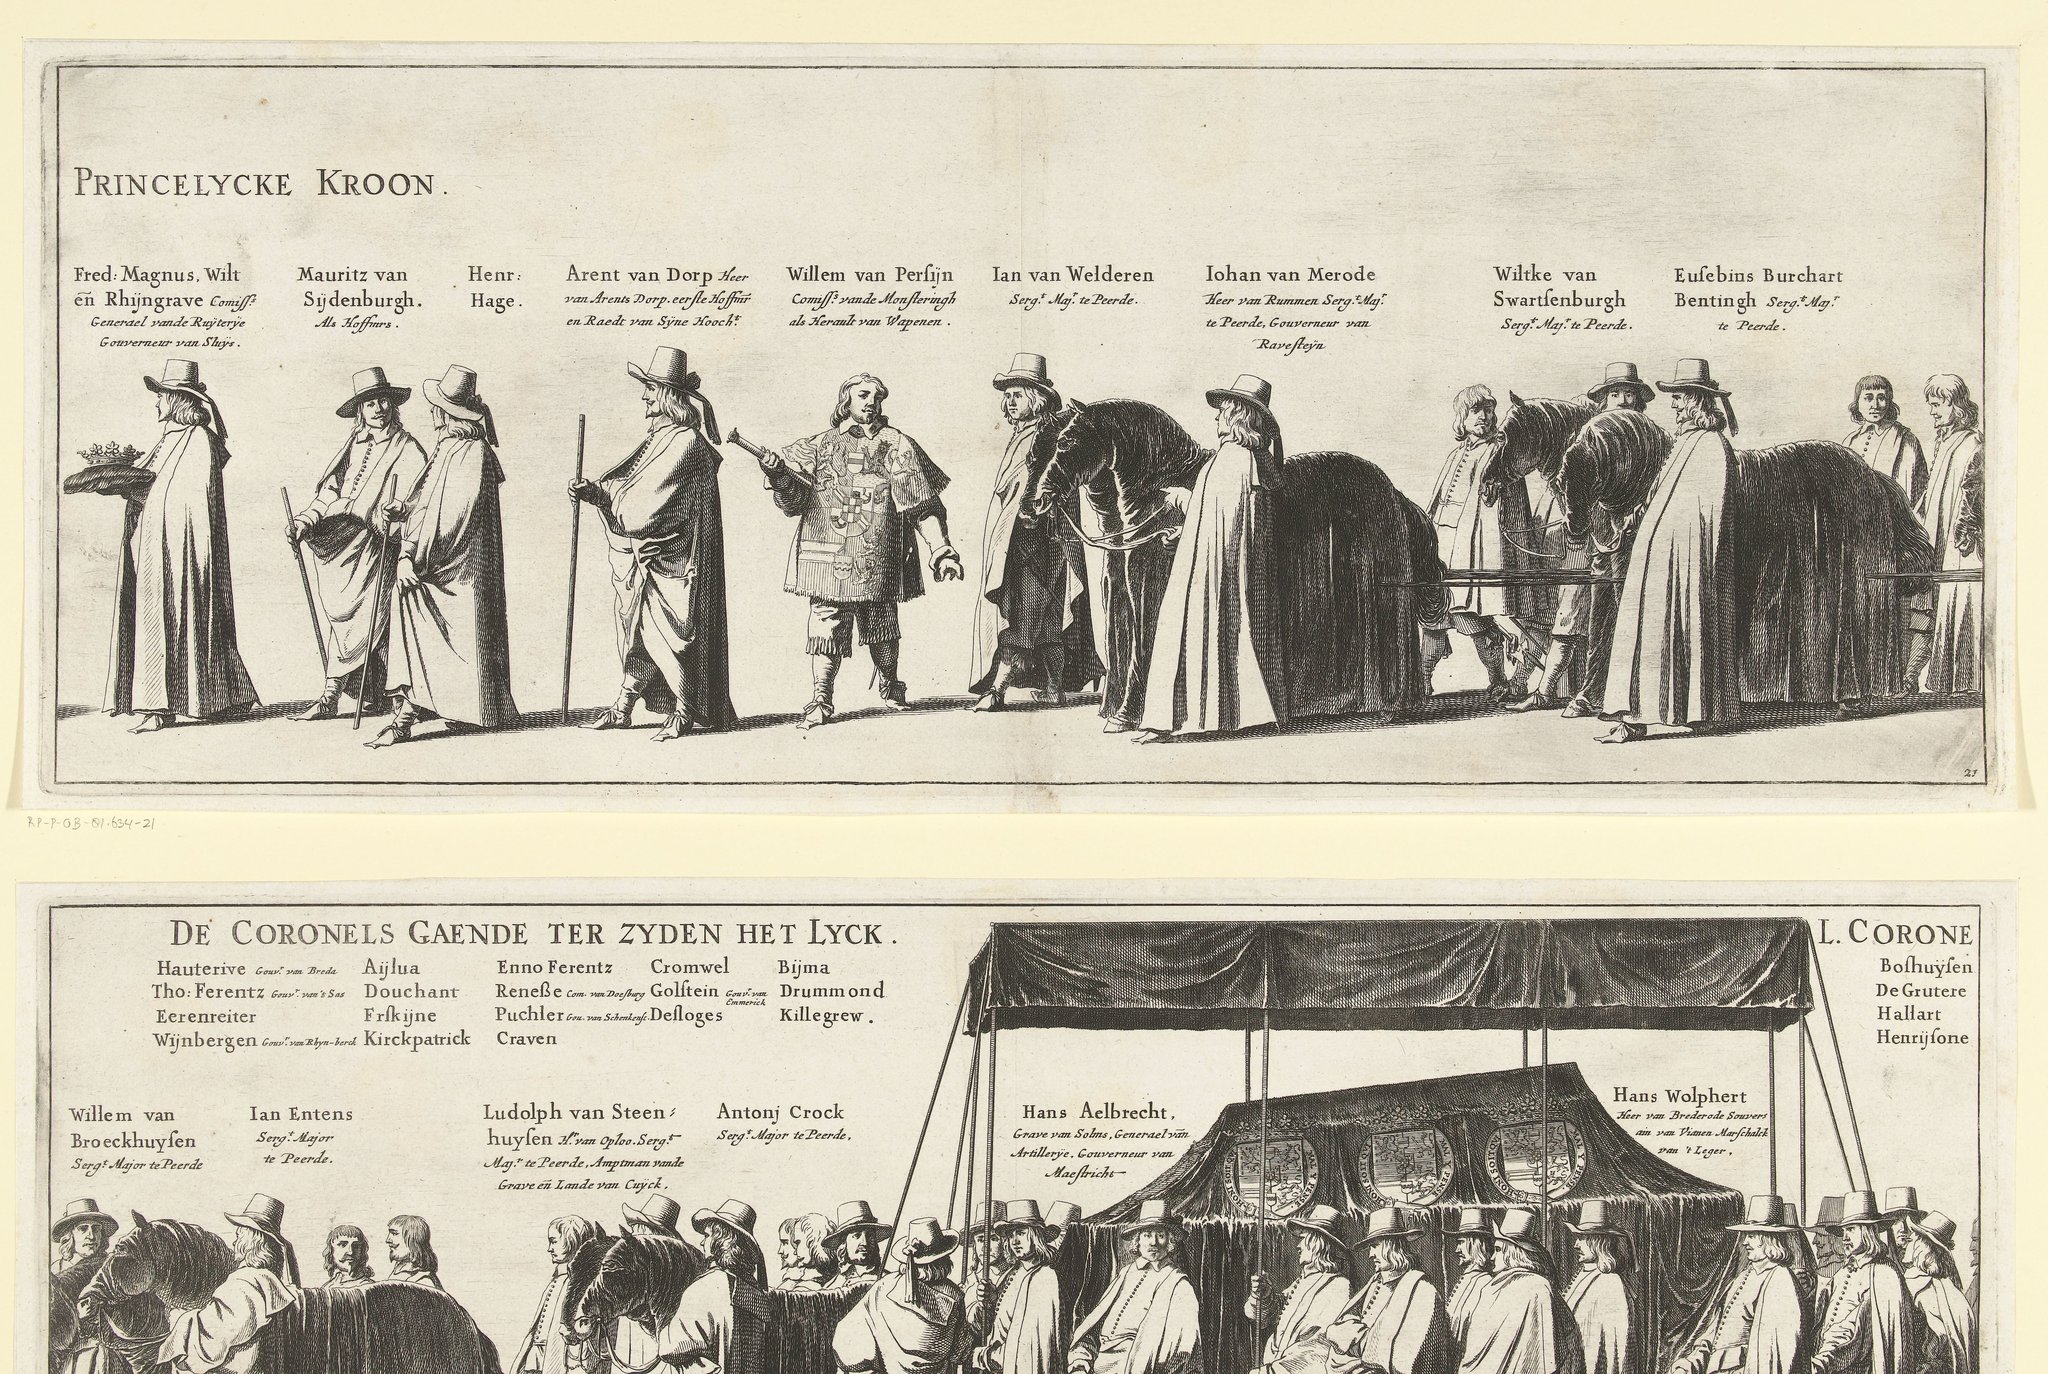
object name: print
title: De begrafenisstoet van Frederik Hendrik (plaat nr. 21), 1647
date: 1647-1651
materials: paper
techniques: etching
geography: amsterdam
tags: the hague, frederick henry (prince of orange), cortege, funeral procession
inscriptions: collector's mark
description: De begrafenisstoet van stadhouder Frederik Hendrik te 's-Gravenhage op 10 mei 1647. Plaat nr. 21 met een deel van de stoet met de drager van de prinselijke kroon en de eerste vier paarden van de lijkwagen, boven de personen staan hun naam en functie. Onderdeel van een serie van 30 platen en 20 tekstbladen, bedoeld om aan elkaar geplakt te worden.